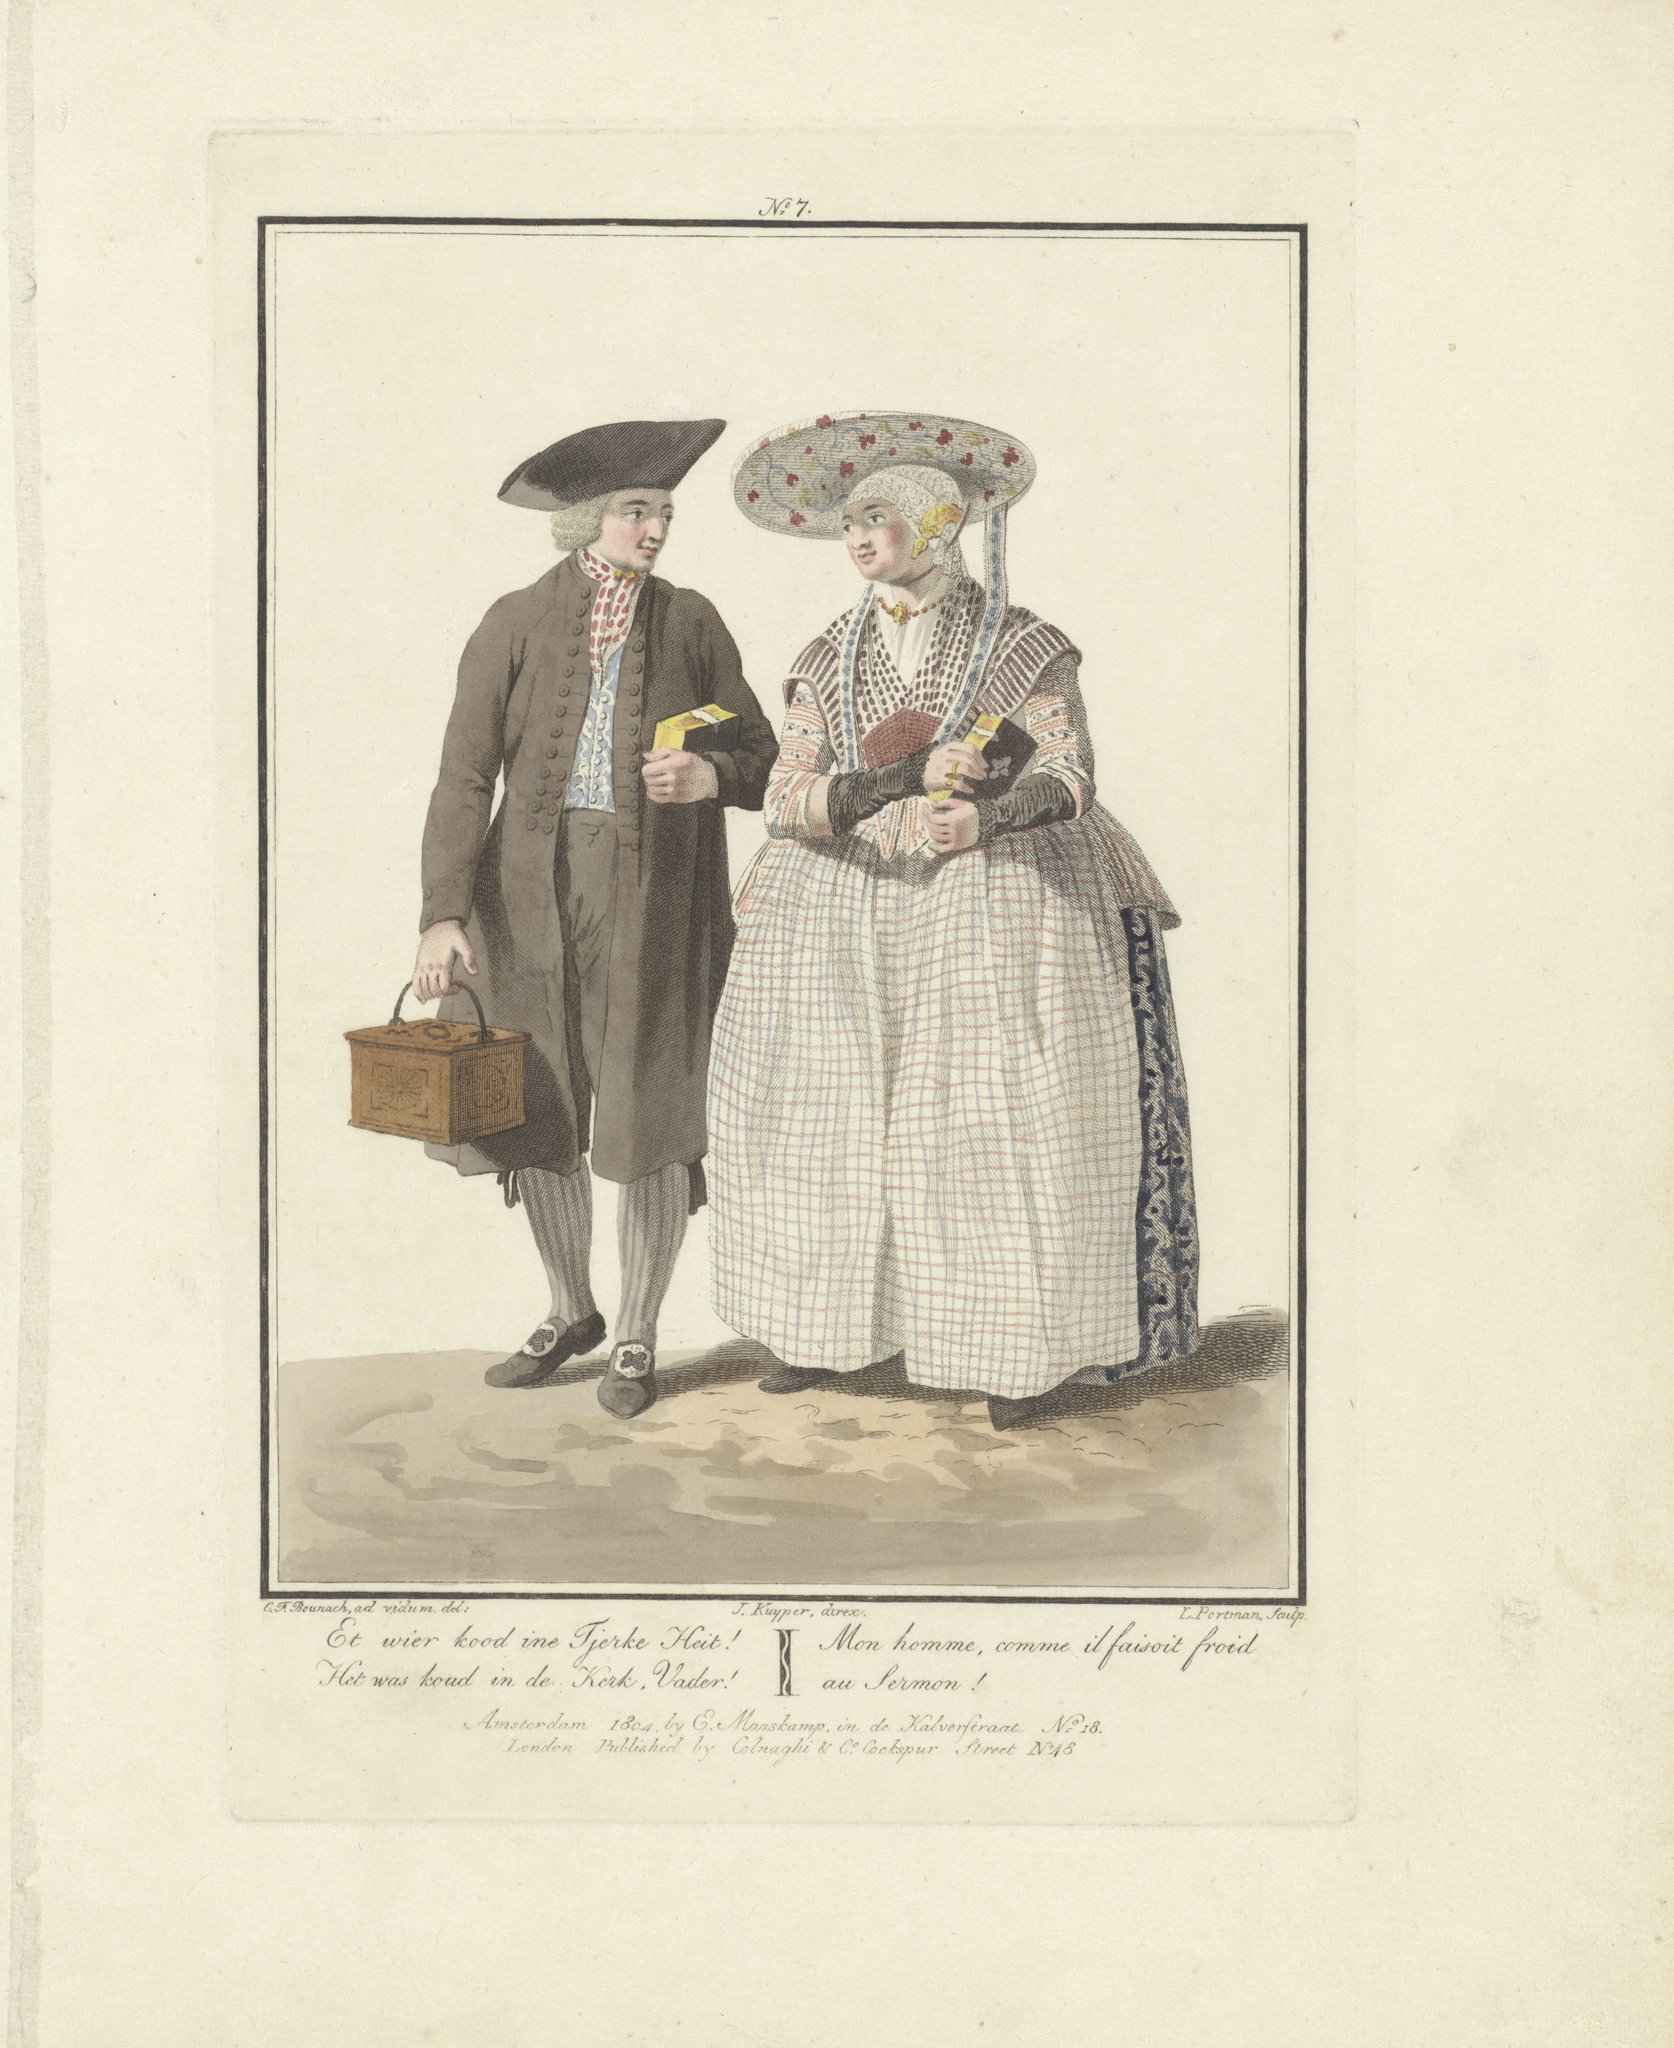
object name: book illustration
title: Paar in Friese klederdracht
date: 1803-1807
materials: paper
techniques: etching, hand coloring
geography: amsterdam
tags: folk costume, regional costume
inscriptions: collector's mark: Lugt 2228, signature and date: ‘r.o.: L. Portman sculp.; l.o. J. Kuyper direx.; m.o. Amsterdam 1804 by E. Maaskamp’, inscription: ‘Et wier kood ine Tjerke, Heit...Mon homme, comme il faisoit froid....’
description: Illustratie uit: Afbeeldingen van de kleeding, zeden en gewoonten in de Bataafsche Republiek, met den aanvang der negentiende eeuw. Amsterdam: Evert Maaskamp, 1803-1807.